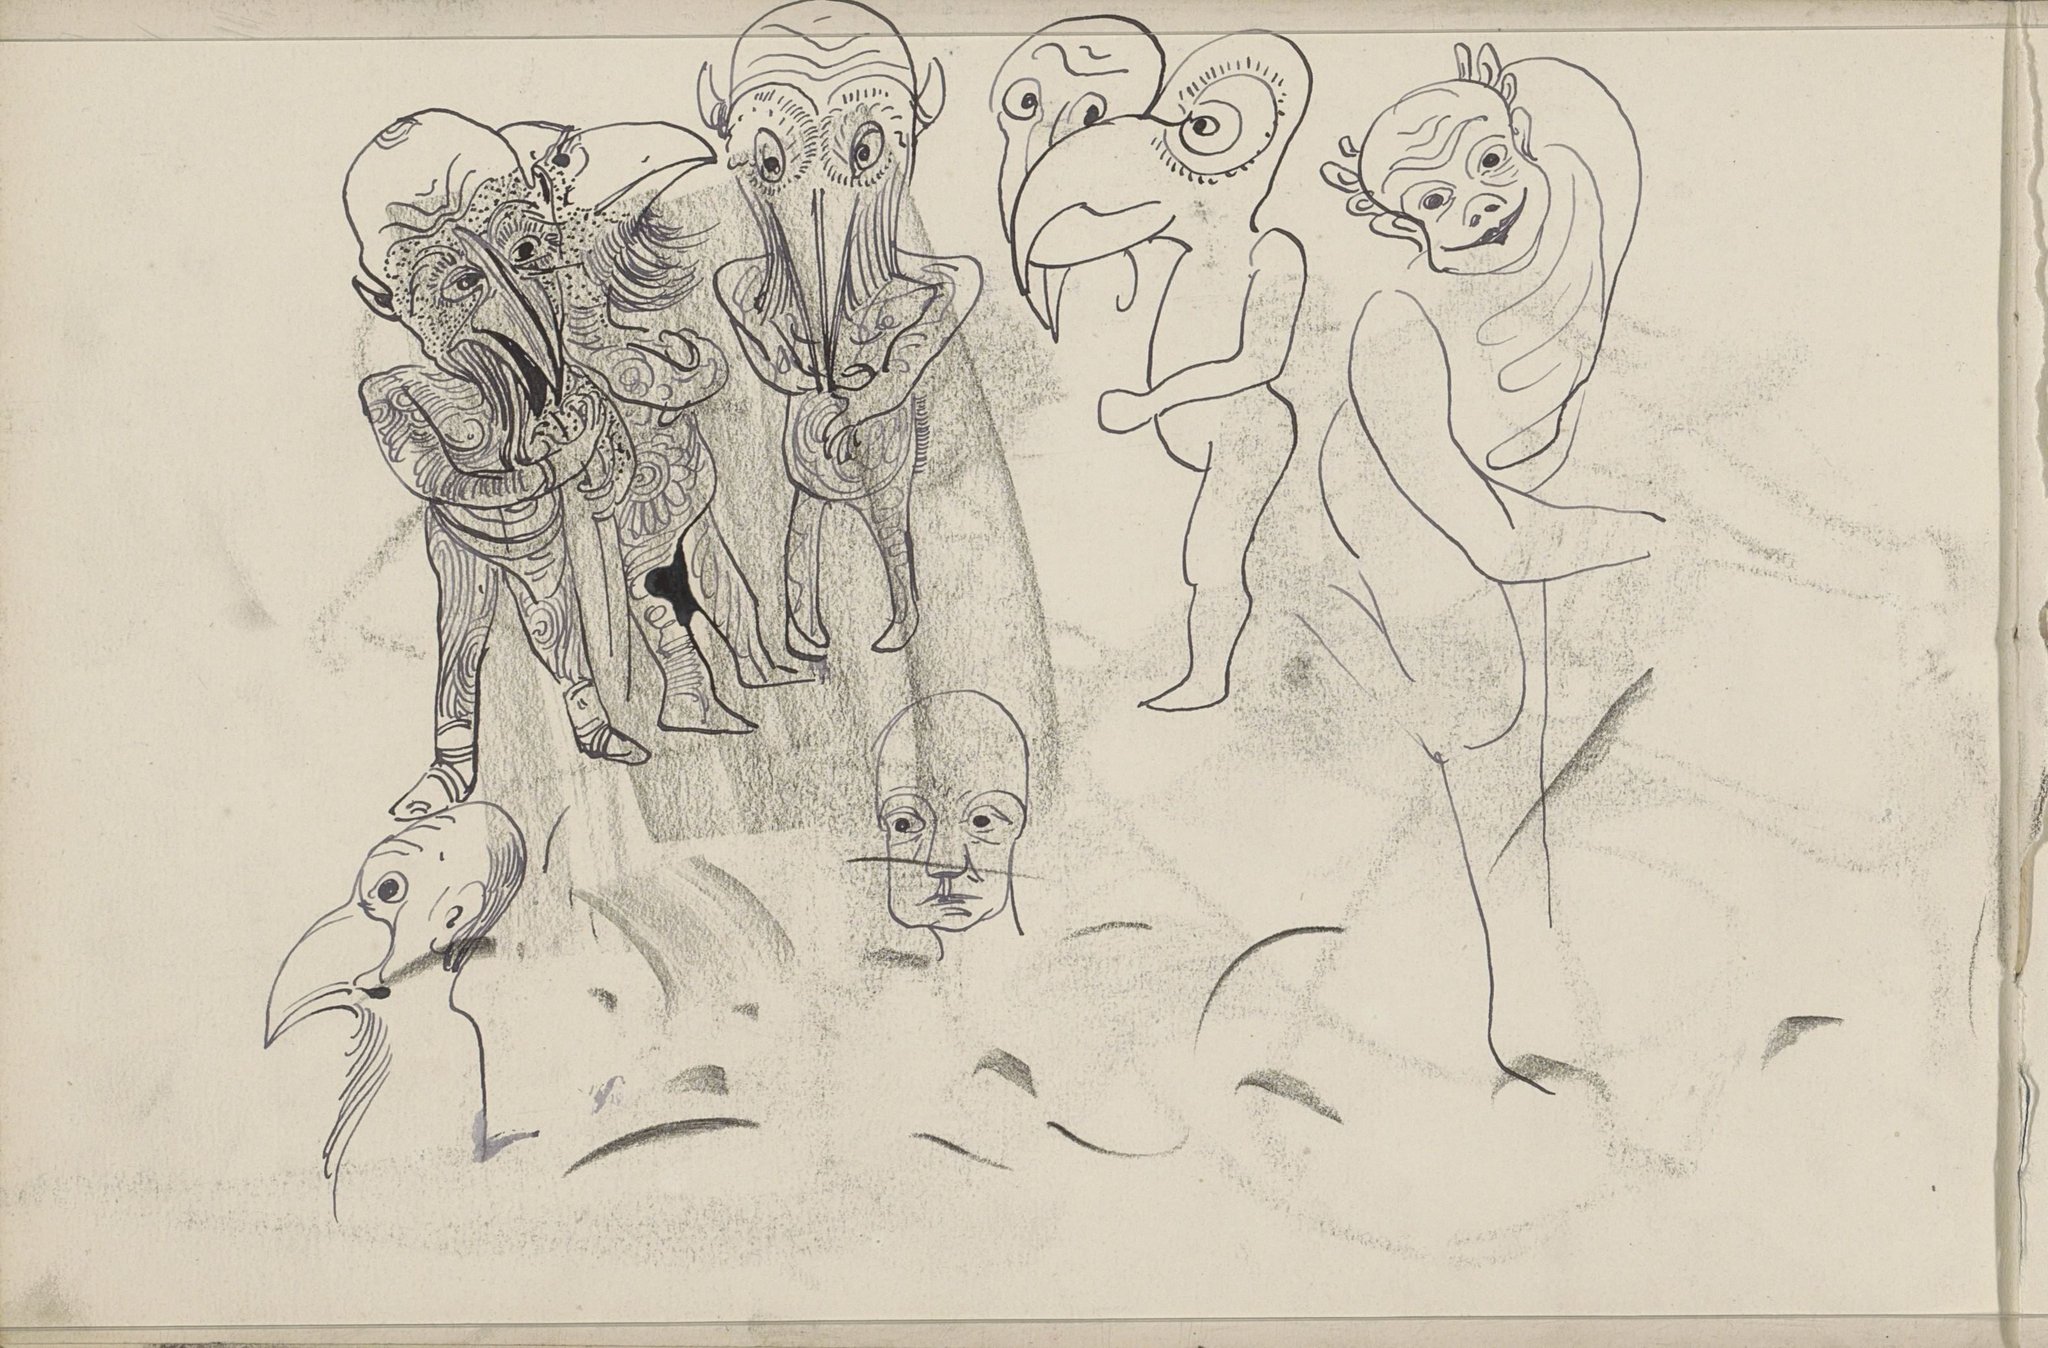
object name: sketchbook leaf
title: Menselijke figuren met snavels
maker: carel adolph lion cachet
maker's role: draughtsman, print maker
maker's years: 1864-1945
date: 1895-1900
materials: ink, paper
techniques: pen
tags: head (human), birds, anthropomorphic beings (legendary or not) with heads, limbs or organs of an abnormal number, in abnormal places or of an abnormal shape)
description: Tevens fantasiefiguren, een kop en een vogel. Blad 8 verso uit een schetsboek met 19 bladen.